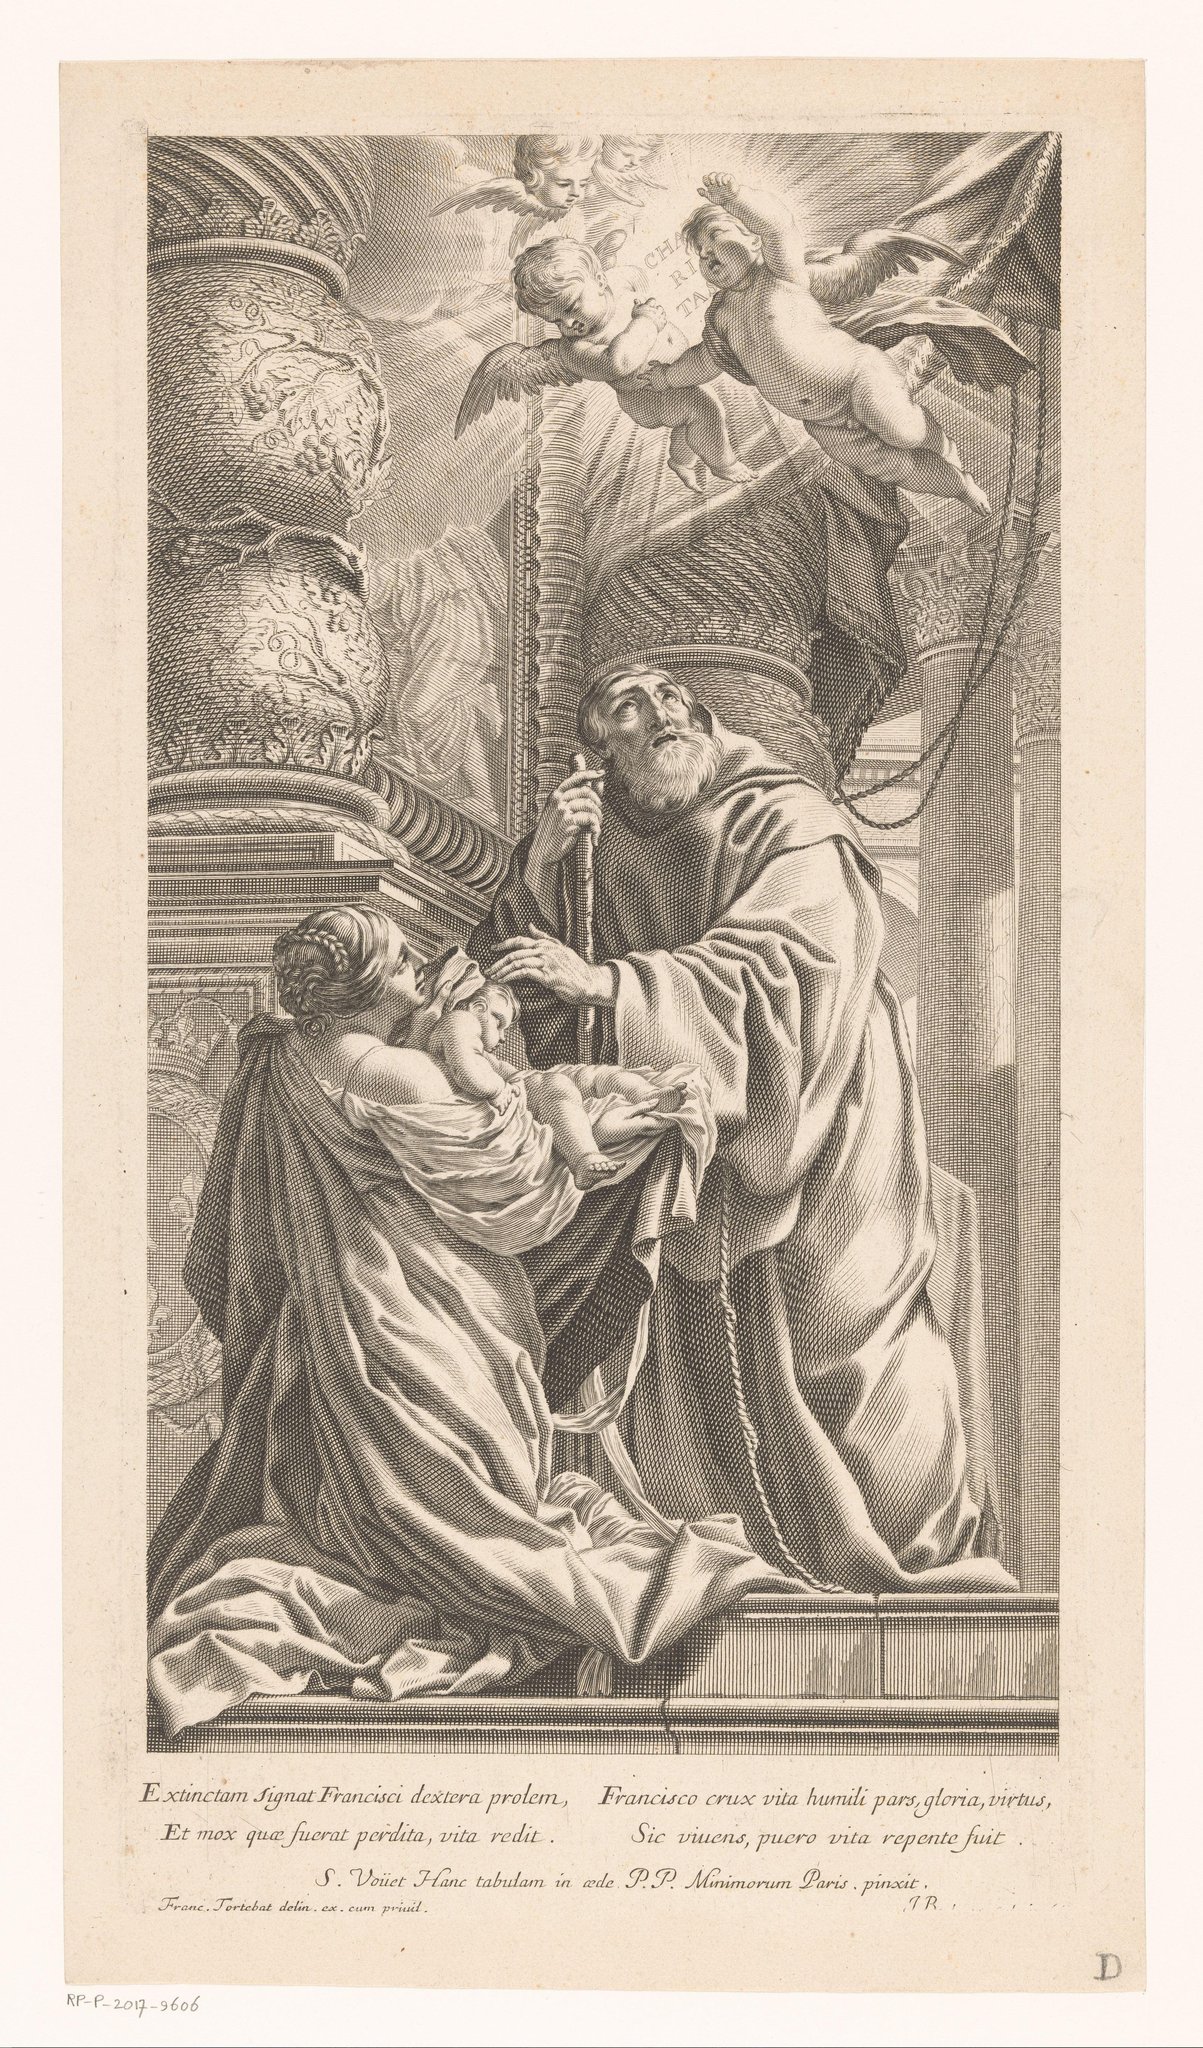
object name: print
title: H. Franciscus van Paola wekt een kind tot leven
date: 1655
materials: paper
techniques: engraving, etching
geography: paris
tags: st. francis of paola raising a child from the dead, one or more angels appear to st. francis of paola holding a tablet with the inscription 'charitas'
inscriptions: collector's mark: Lugt 2228